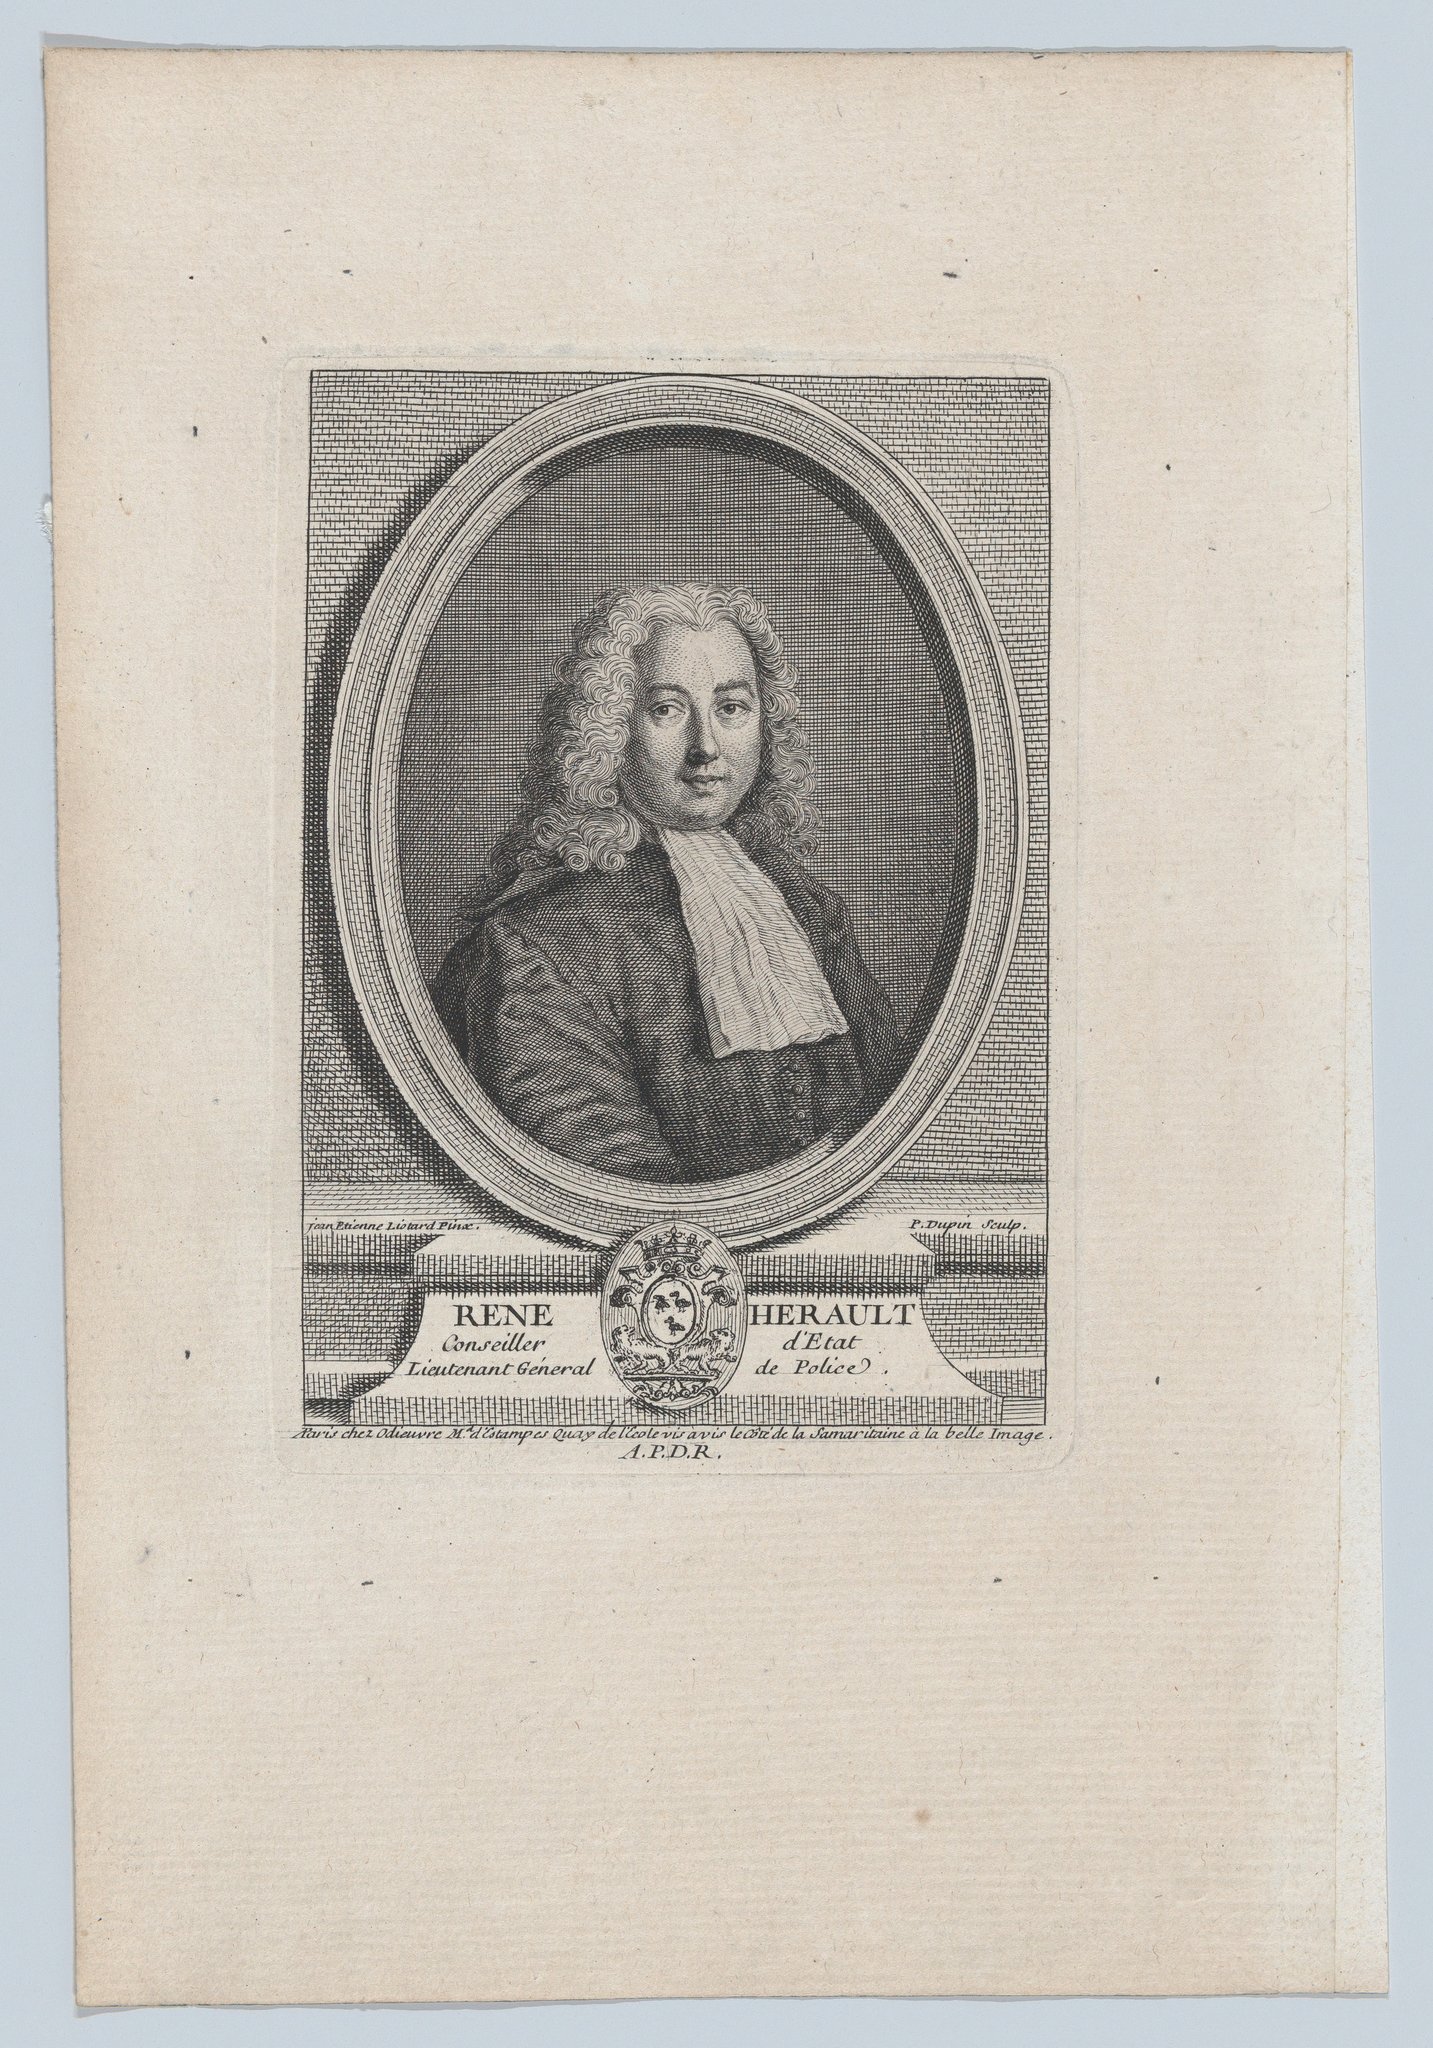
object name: print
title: Portrait of René Herault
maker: pierre dupin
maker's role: artist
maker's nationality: french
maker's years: 1690-1751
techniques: engraving, etching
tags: men,portraits